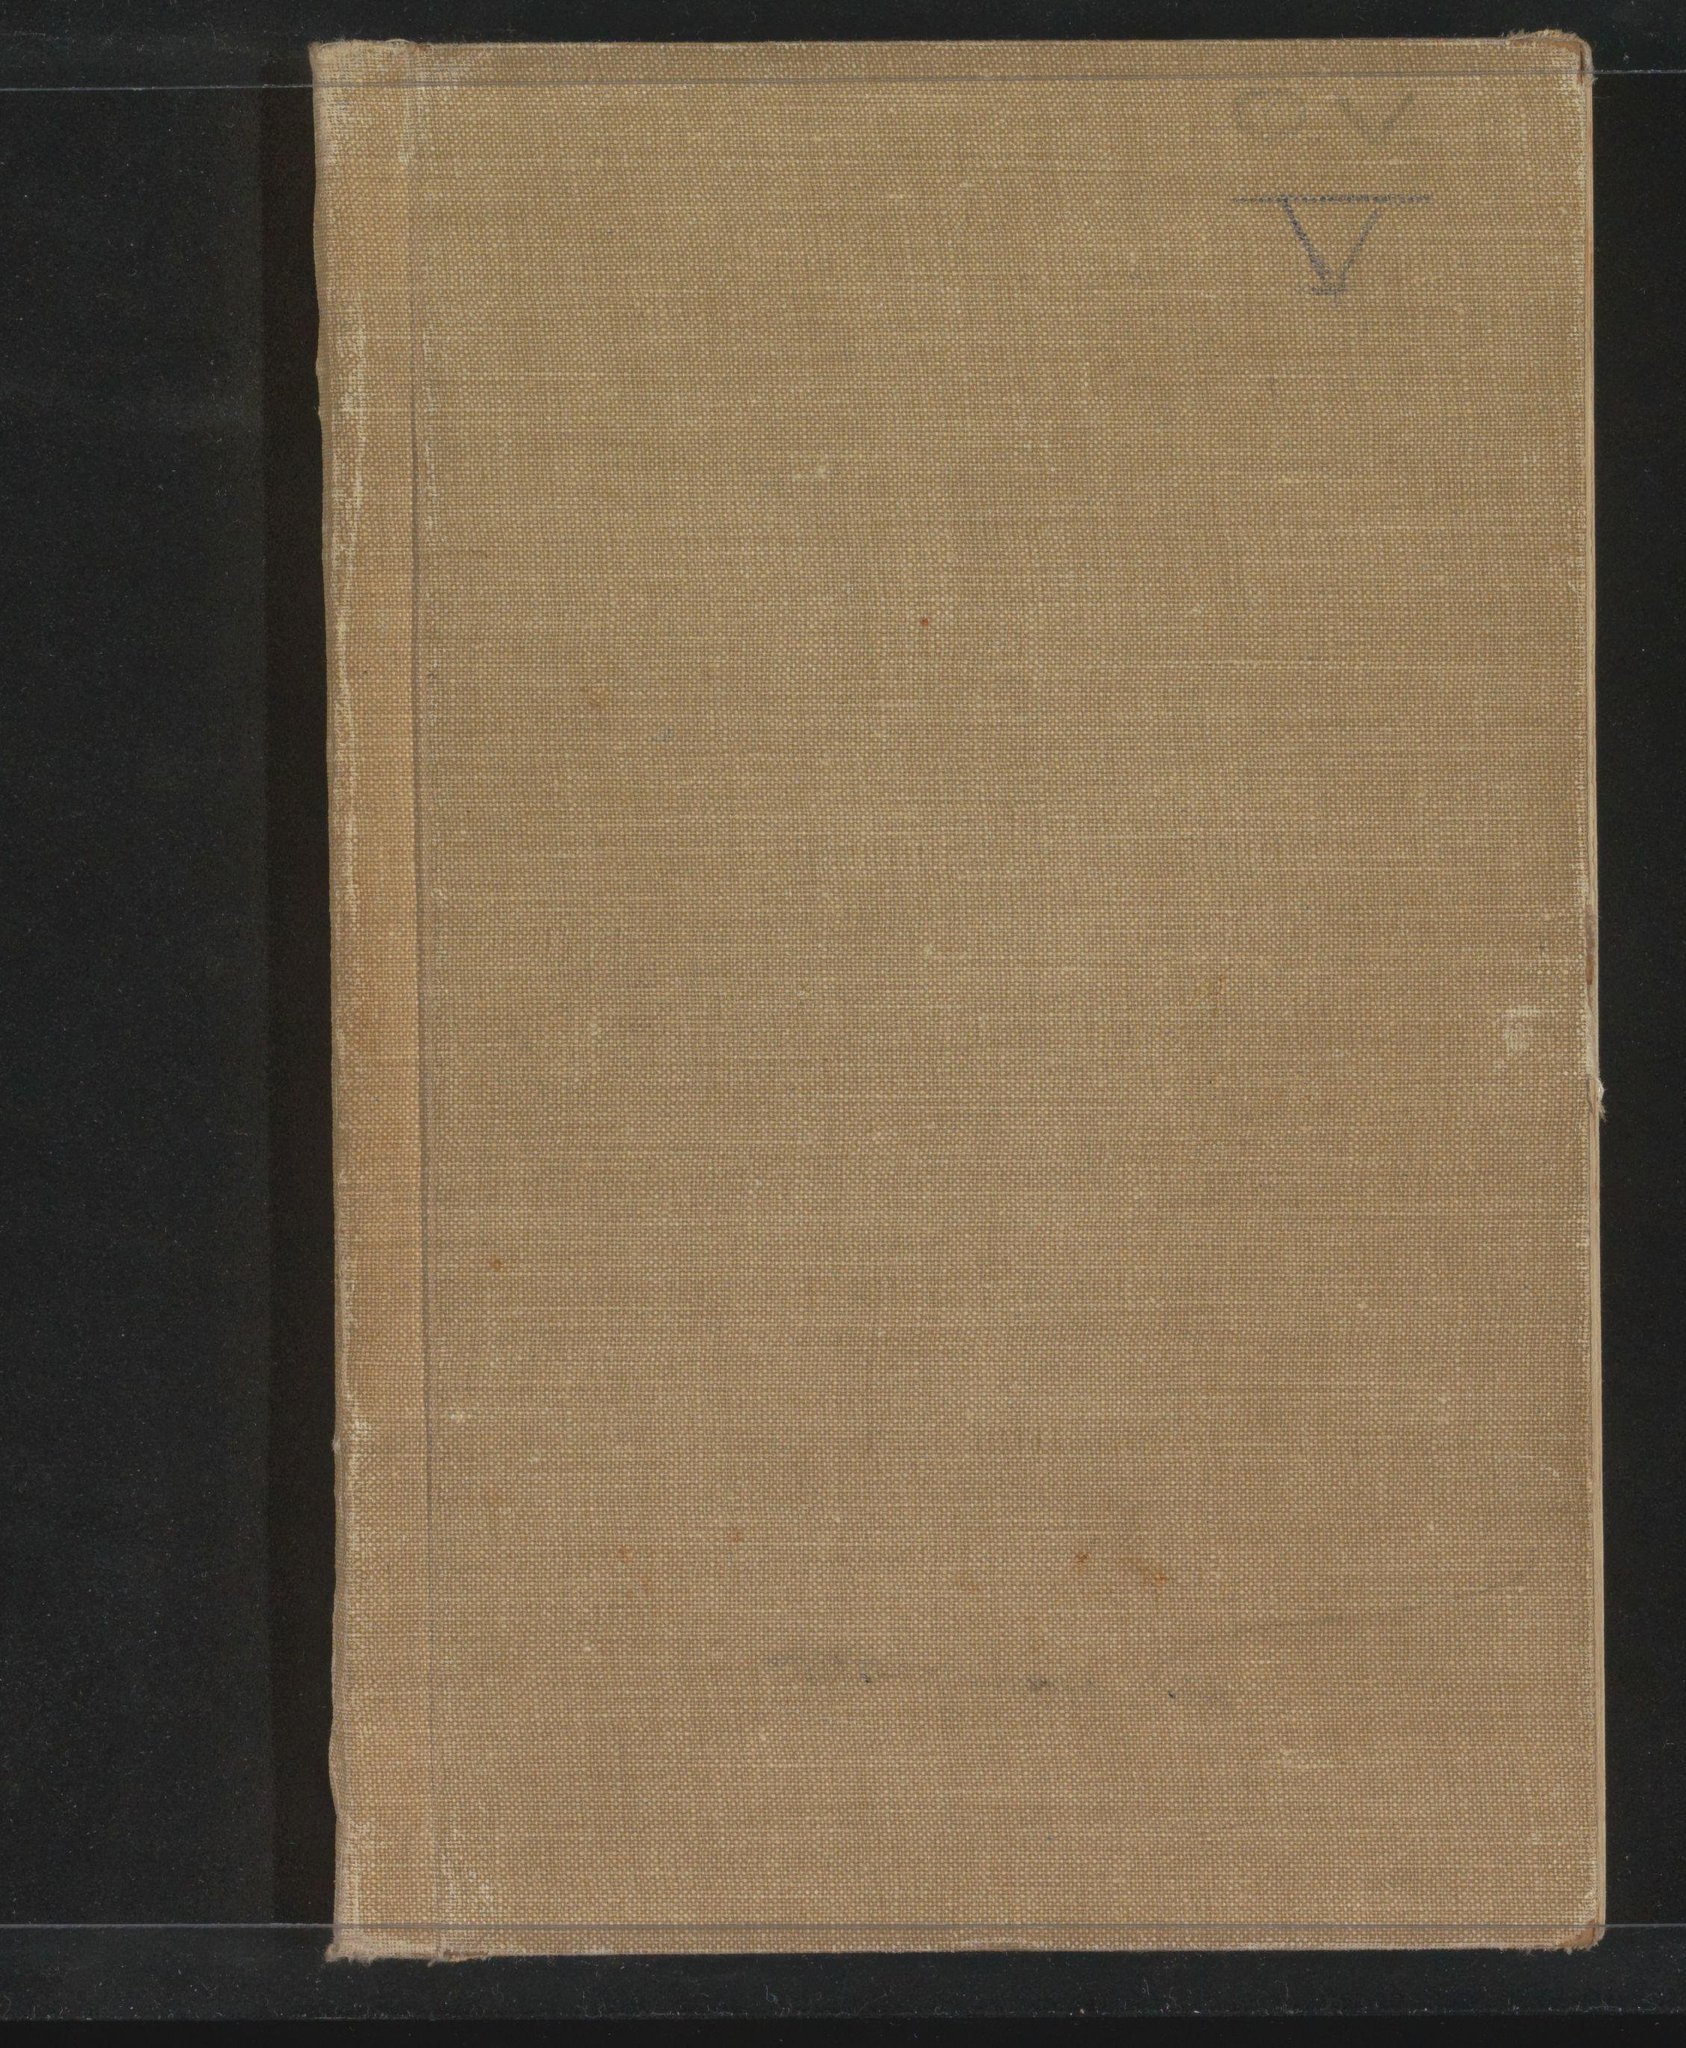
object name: sketchbook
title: Schetsboek met 60 bladen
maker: otto verhagen (i)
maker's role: draughtsman, print maker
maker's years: 1885-1951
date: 1930-1940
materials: cardboard, chalk, linen, paper, pencil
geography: middelburg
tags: beach (as place of recreation), city-view, and landscape with man-made constructions, children's games and plays, ornamental birds, anatomy (non-medical), middelburg, rotterdam, brussels, flushing, bruges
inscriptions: bookplate: ‘Ex/ Libris/ Otto/ Verhagen’, inscription: ‘O.V./ V’, factory mark: ‘SKETCHER'S/ NOTE BOOK/ SERIES A 42./ containing 80 leaves of good white paper,/ MANUFACTURED BY/ GEO. ROWNEY & Co., LONDON, W., ENGLAND./ SIZE No. 2- 8 1/2 x 5 1/2 inches/ Dimensions de l'album 14 x 10 cm.’, collector's mark: Lugt 2228a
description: Schetsboek bestaande uit 60 bladen met studies van strandgangers, stad- en straatgezichten, portretten, vogels en reisimpressies in België en Duitsland.